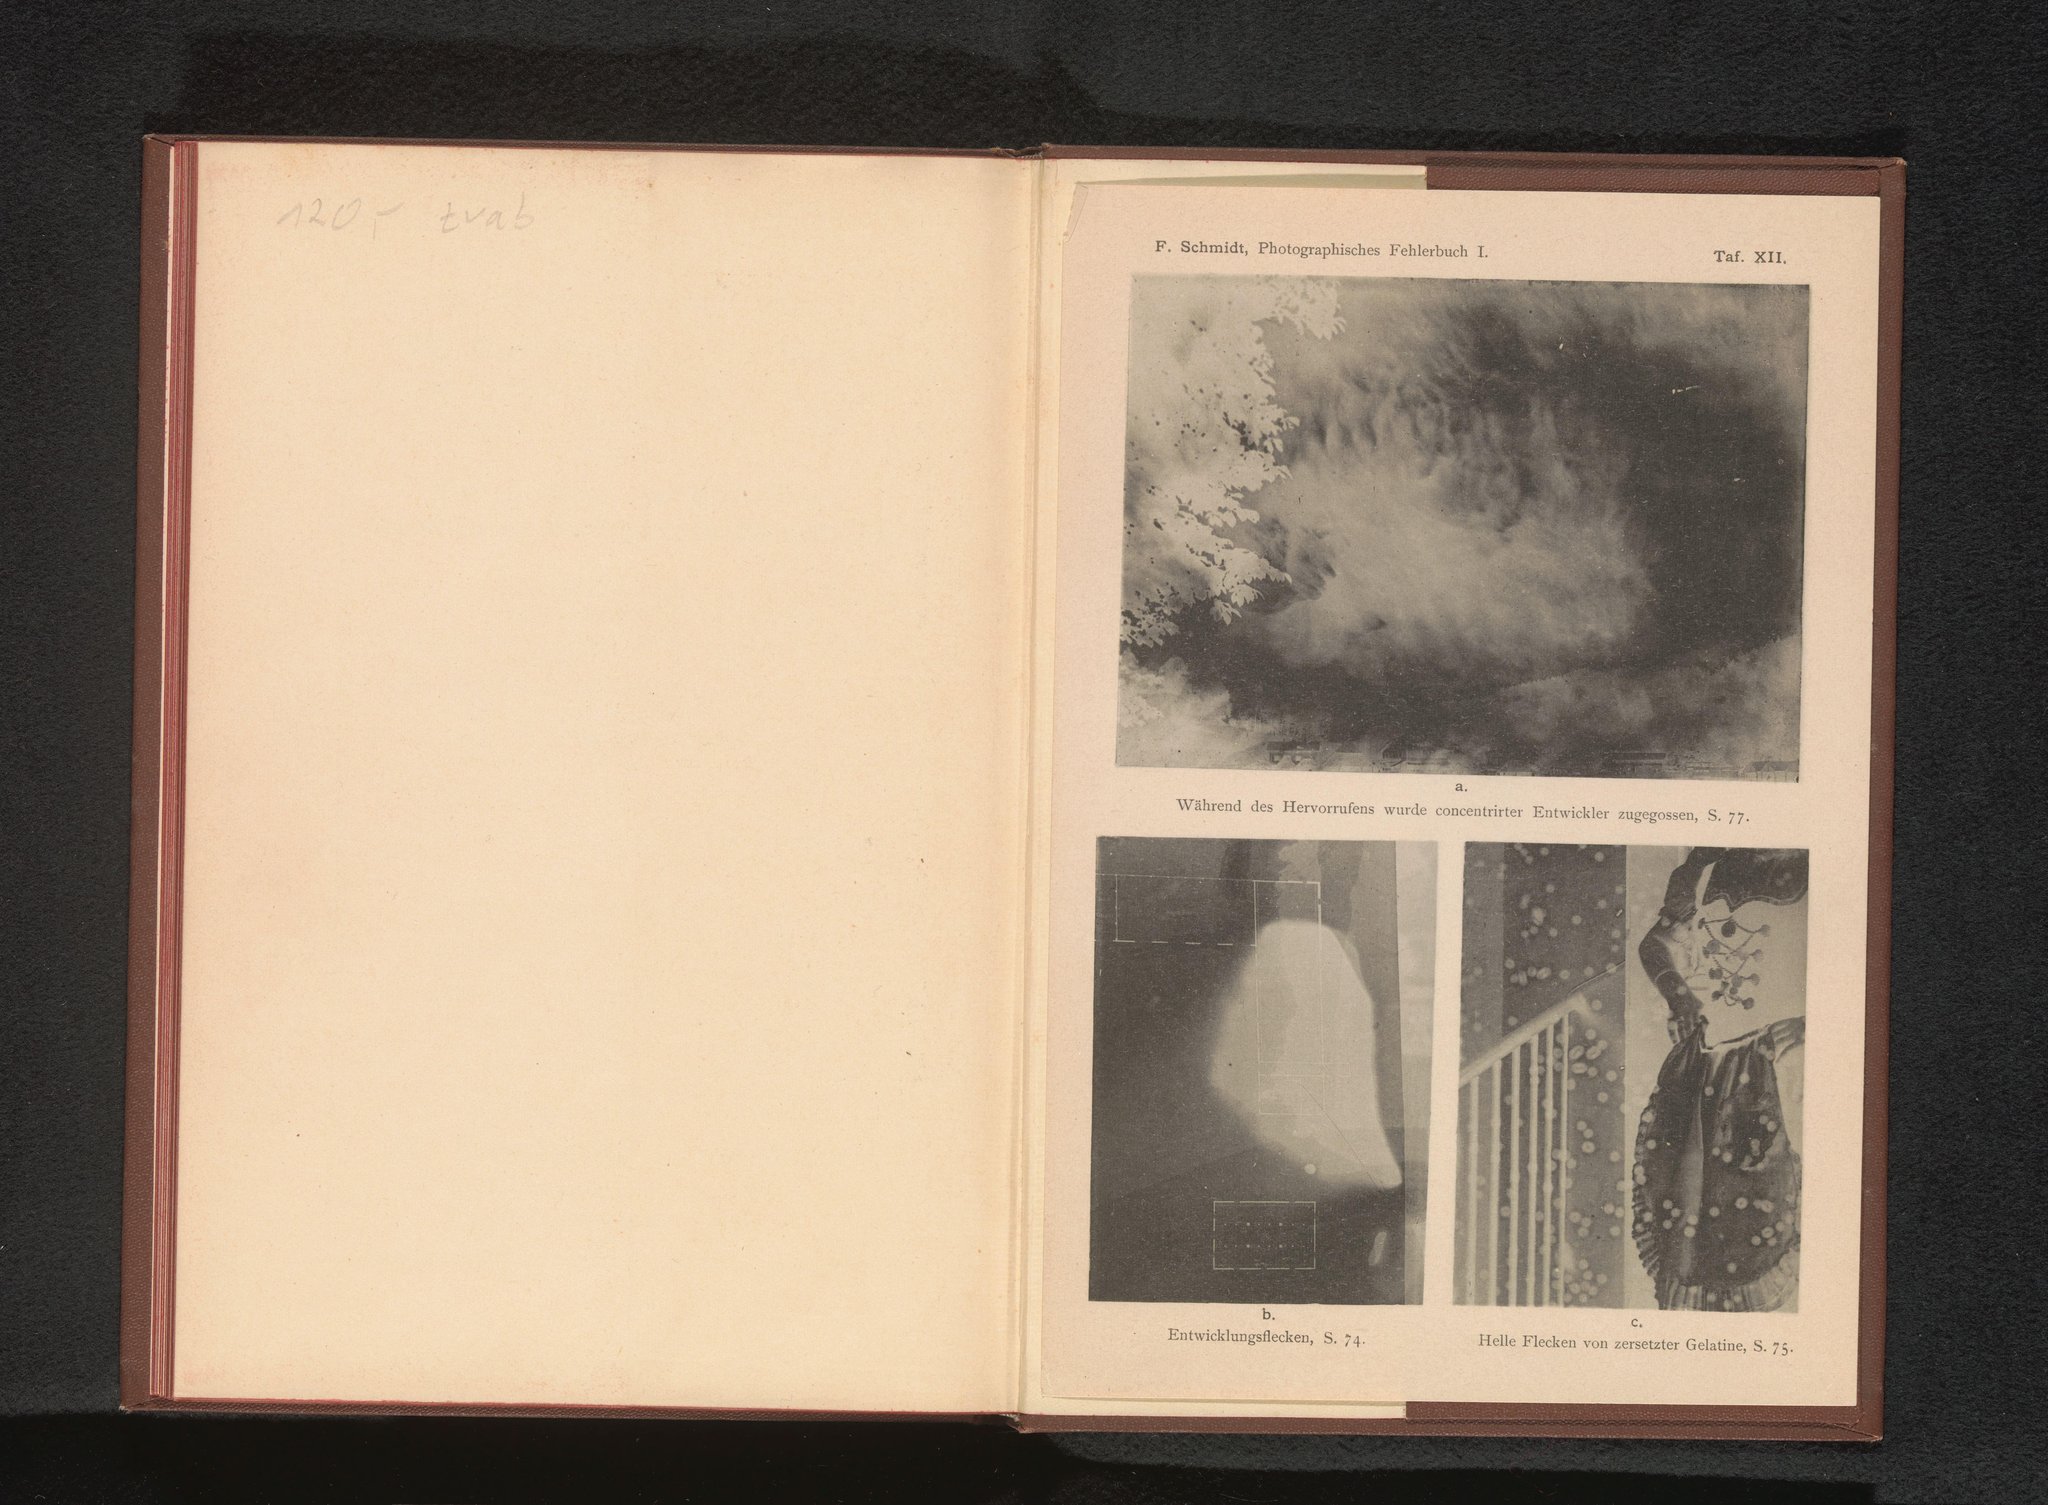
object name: page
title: Drie voorbeelden van vlekken voorkomend in negatieven door fouten tijdens het ontwikkelproces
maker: Anonymous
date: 1890-1895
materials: paper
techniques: photograph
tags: negative ~ photography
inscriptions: inscription: ‘a./ Während des Hervorrufens wurde concentrirter Entwickler zugegossen, S. 77/ b./ Entwicklungsflecken, S. 74./ c./ Helle Fecken von zersetzter Gelatine, S. 75.’, number: ‘Taf. XII.’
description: Prenten op losse bladen. Bladen in insteekhoes achterin boek.